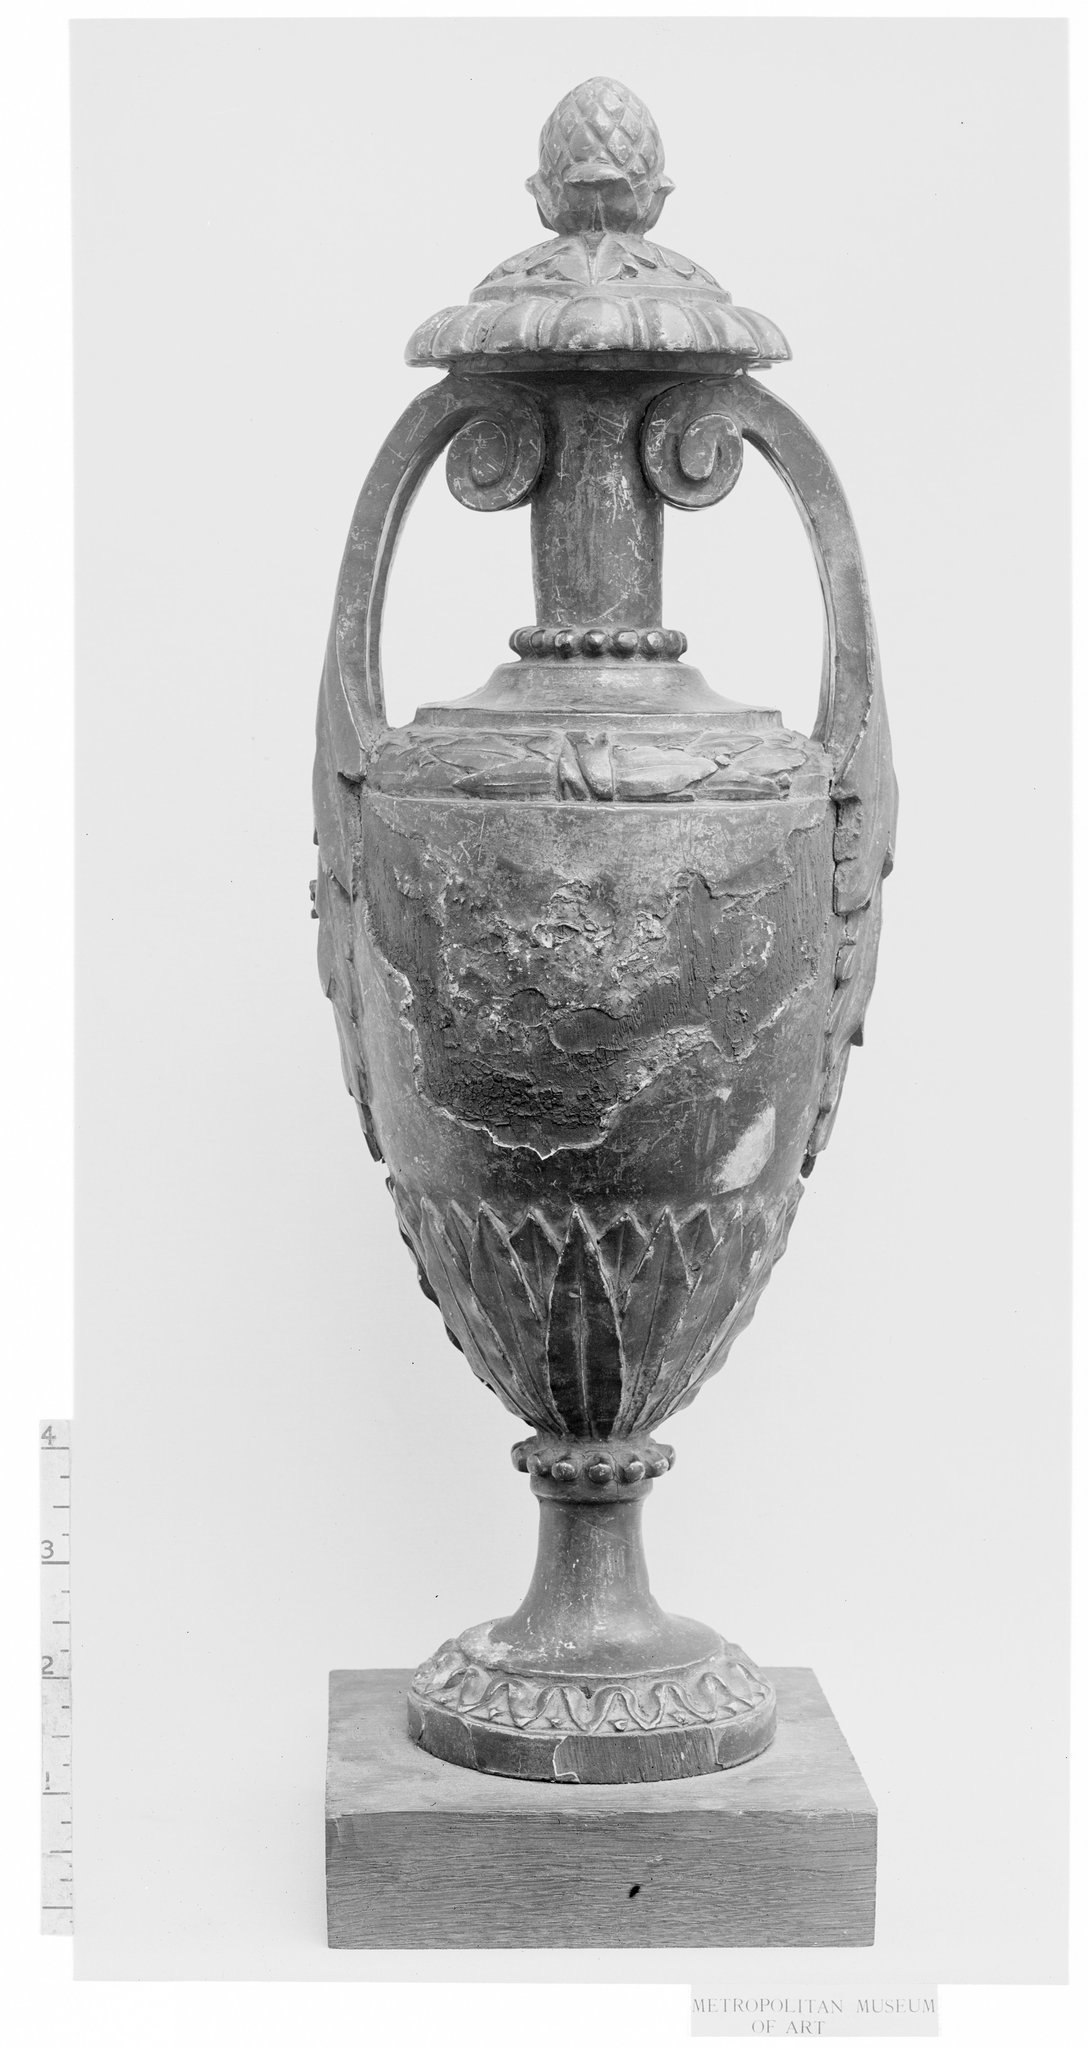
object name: vase ornament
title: Vase ornament for console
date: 1701-1800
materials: gilt, wood